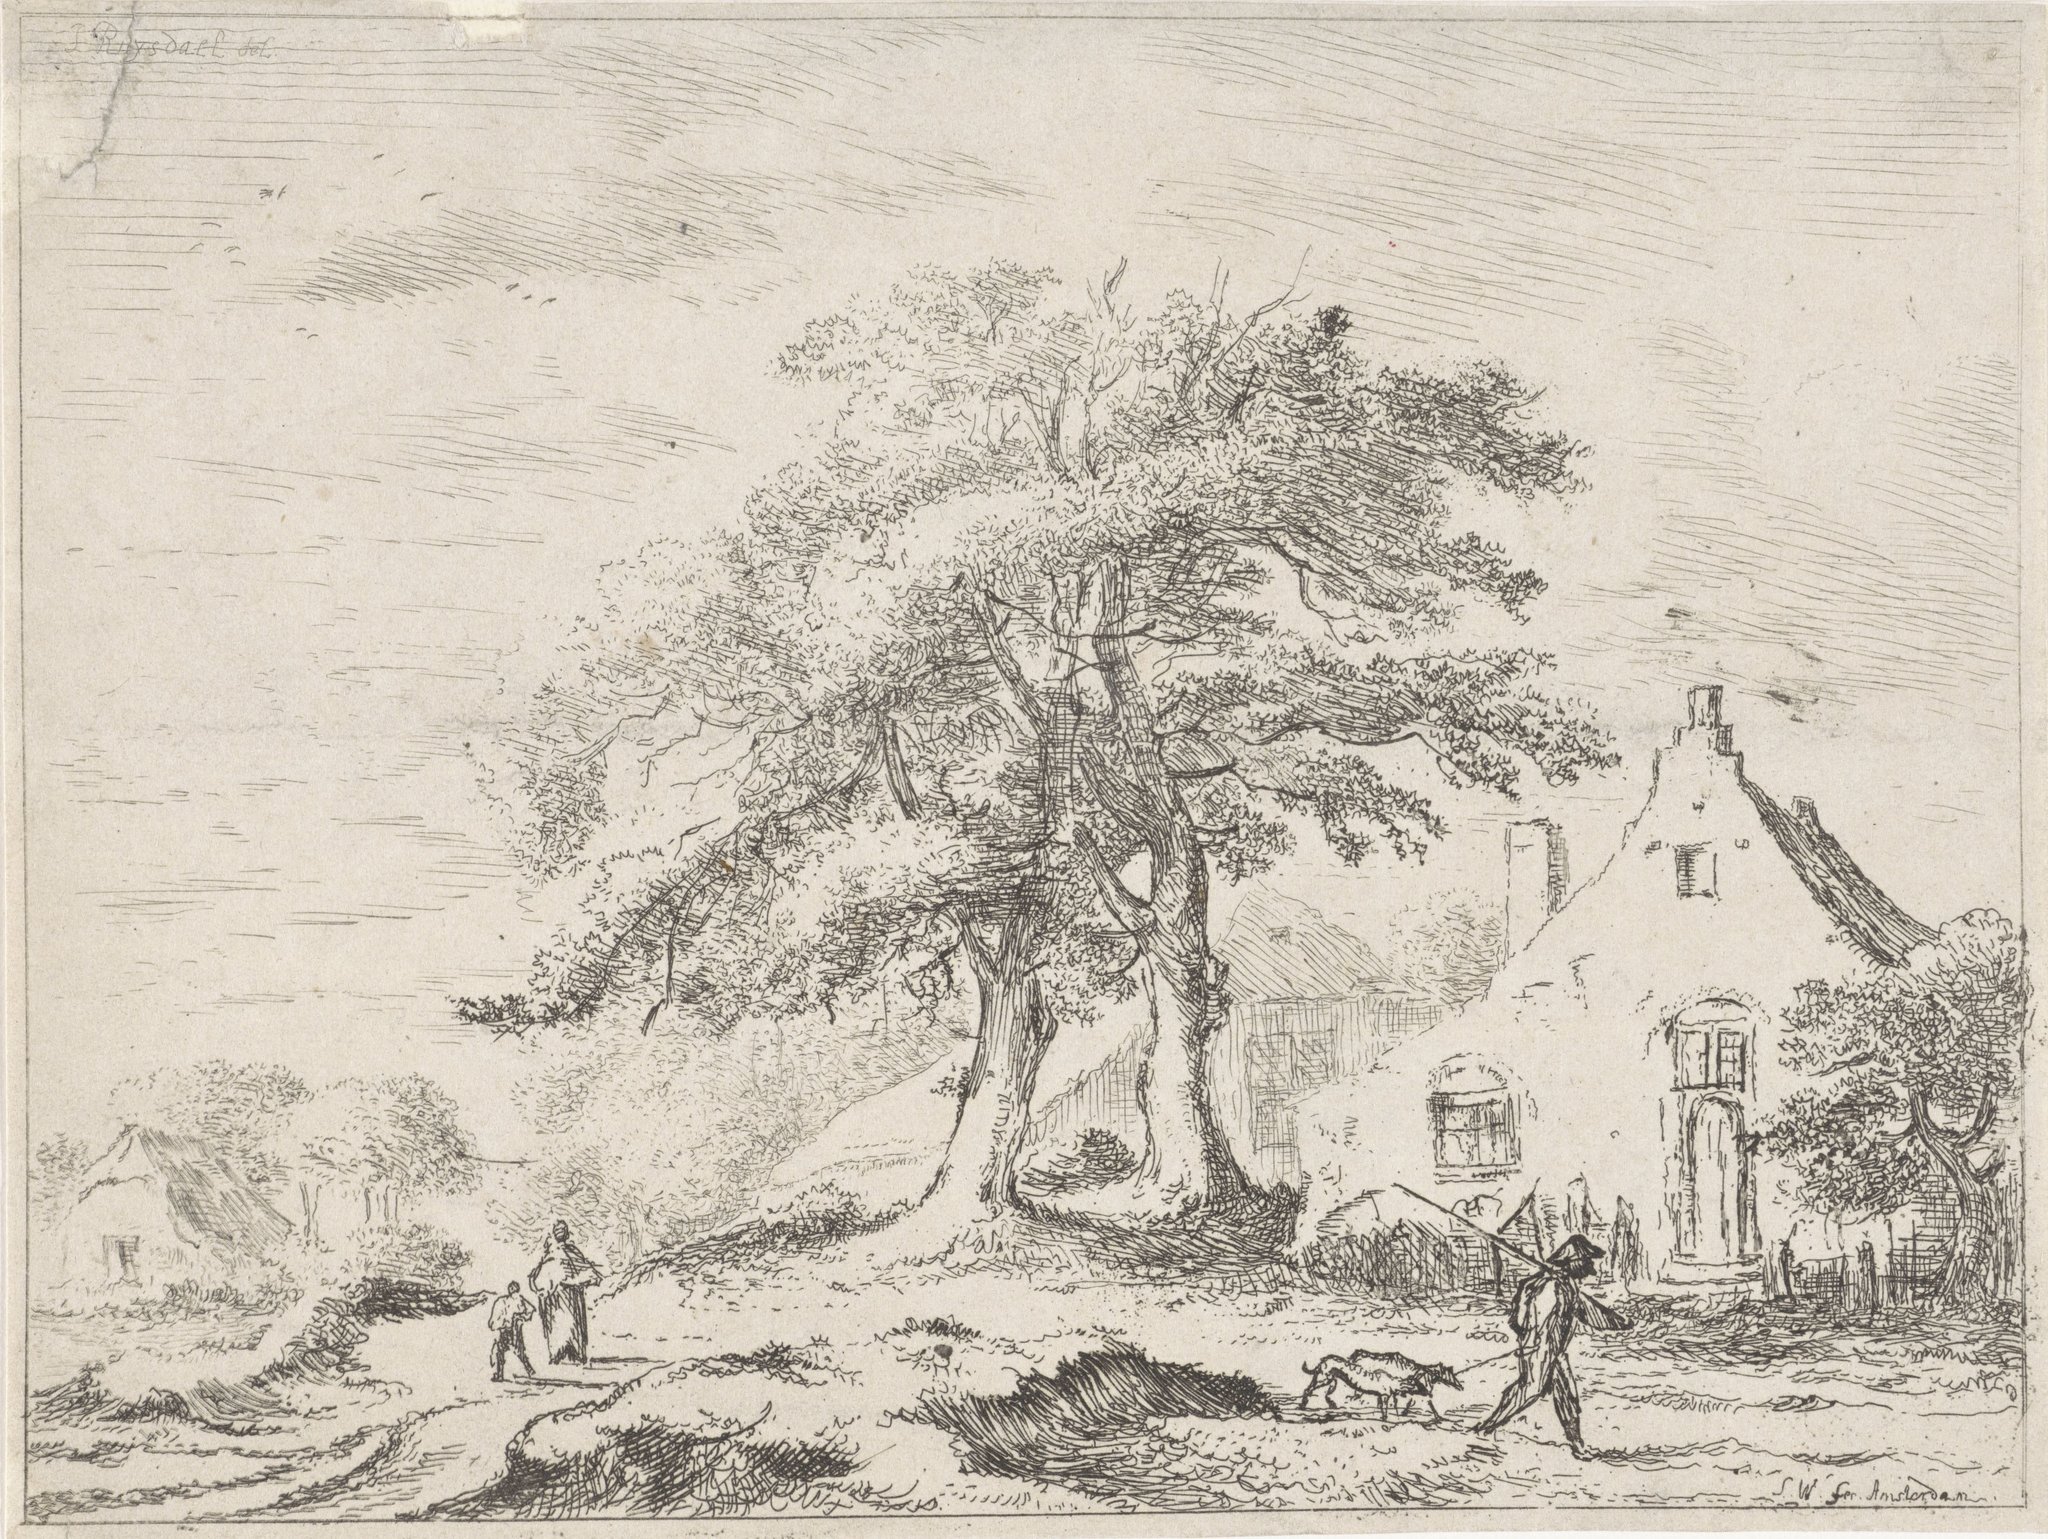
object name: print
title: Landschap met een jager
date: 1700-1799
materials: paper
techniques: etching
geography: amsterdam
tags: hunter, farm or solitary house in landscape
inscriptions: collector's mark: Lugt 2228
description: In een landschap staan drie huizen. Links loopt een vrouw met een kind en rechts loopt een jager met twee honden over een pad.